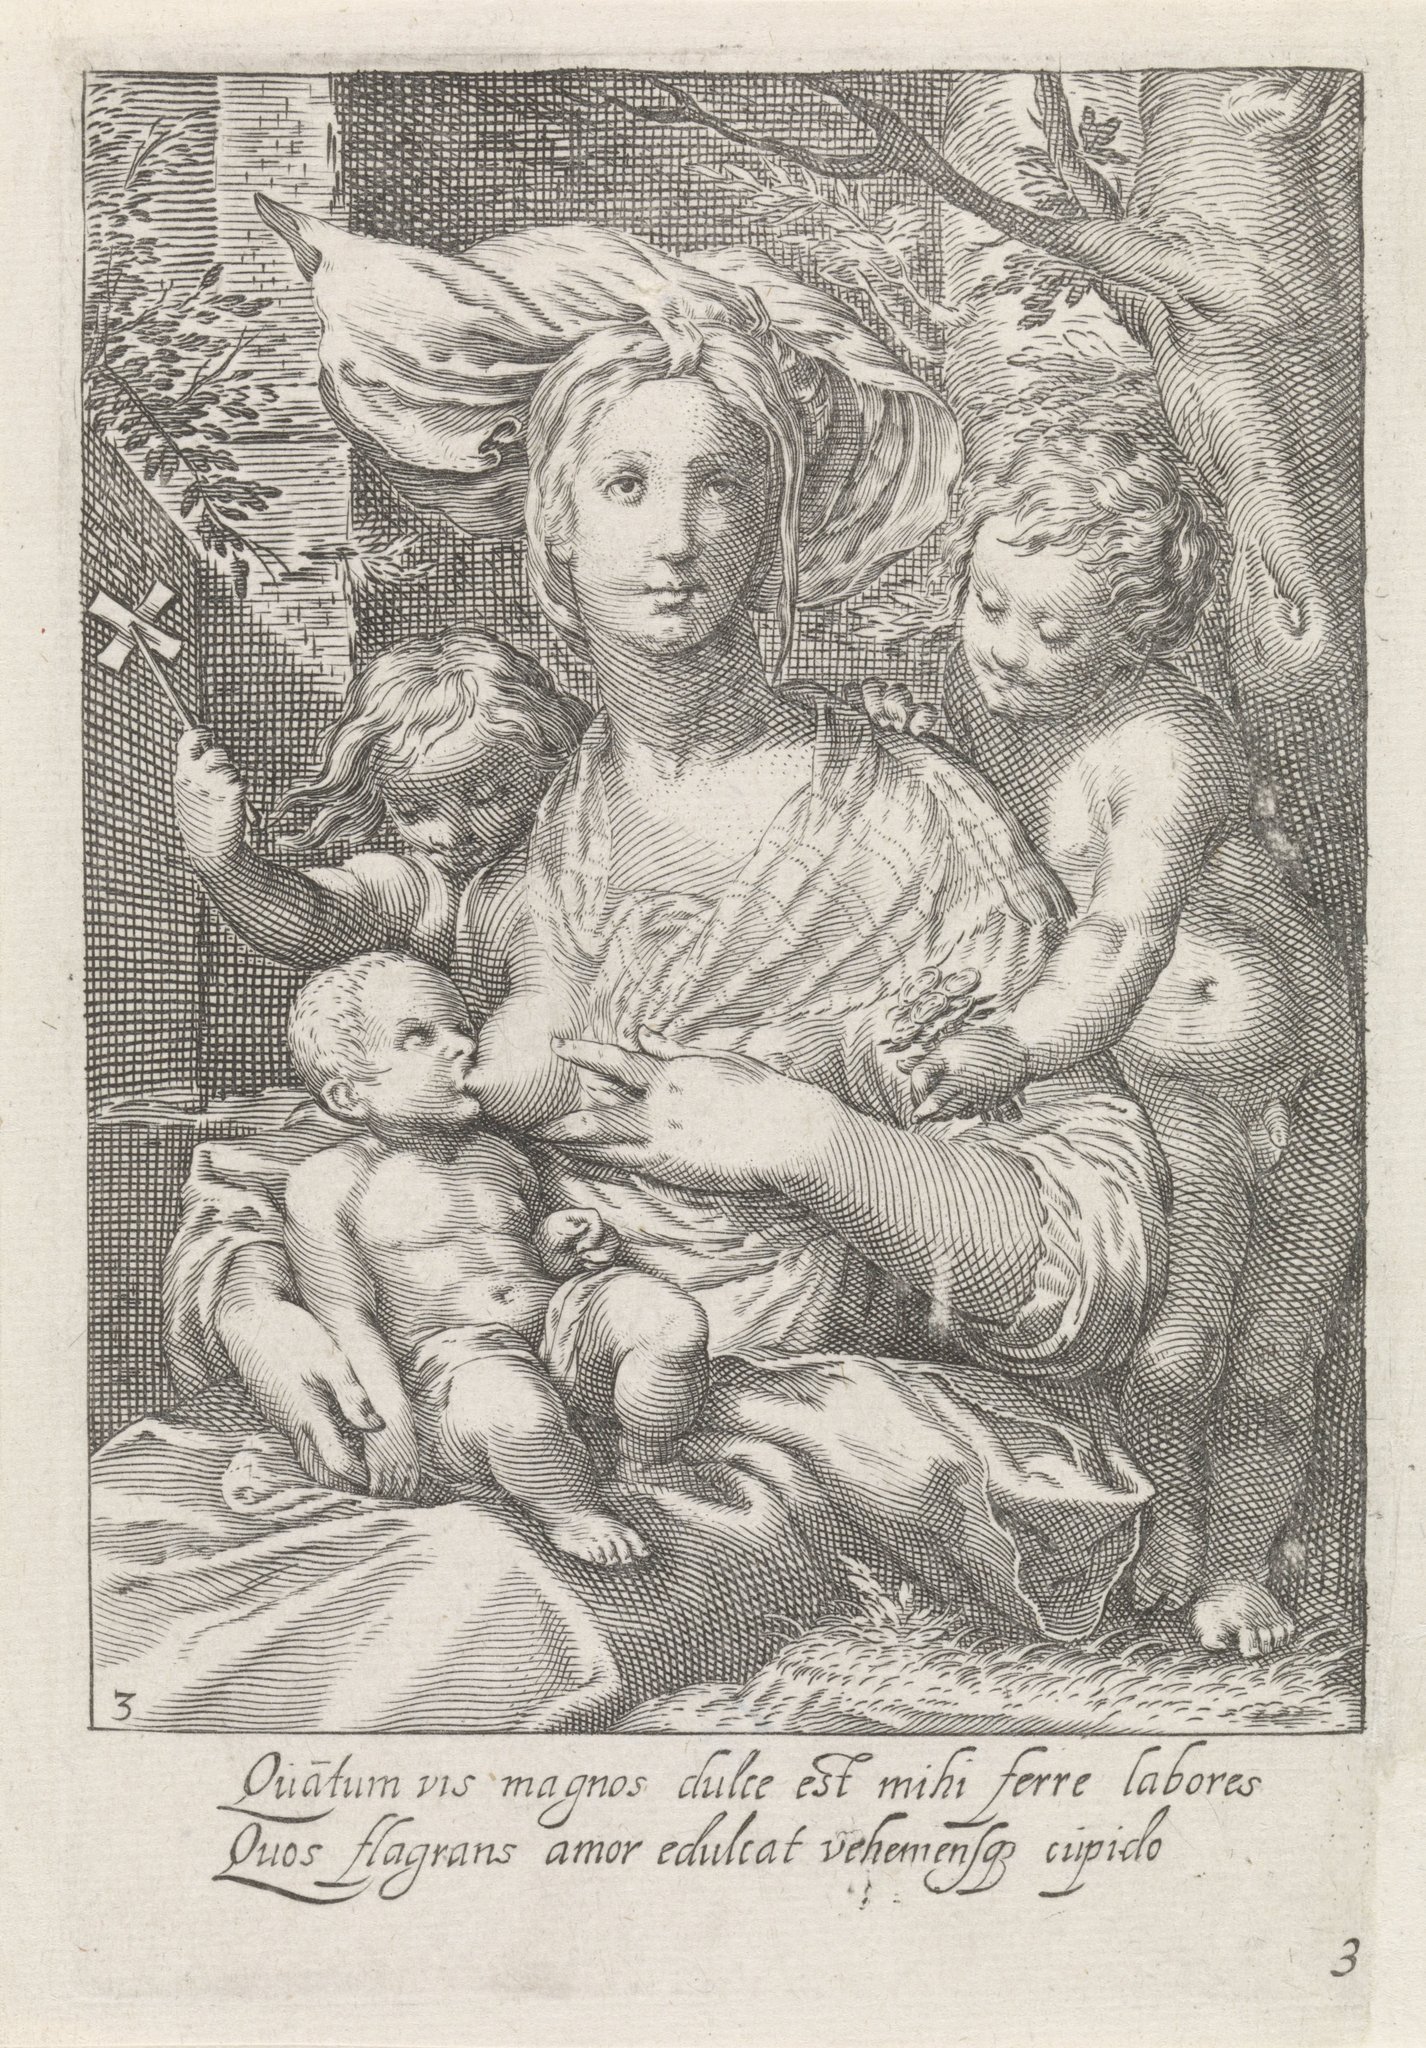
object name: print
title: Liefde (Caritas)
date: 1601-1652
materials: paper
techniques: engraving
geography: amsterdam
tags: charity, 'caritas'; 'carità' (ripa) ~ one of the three theological virtues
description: Een vrouwenfigur omringd met kinderen als personificatie van de liefde (caritas).